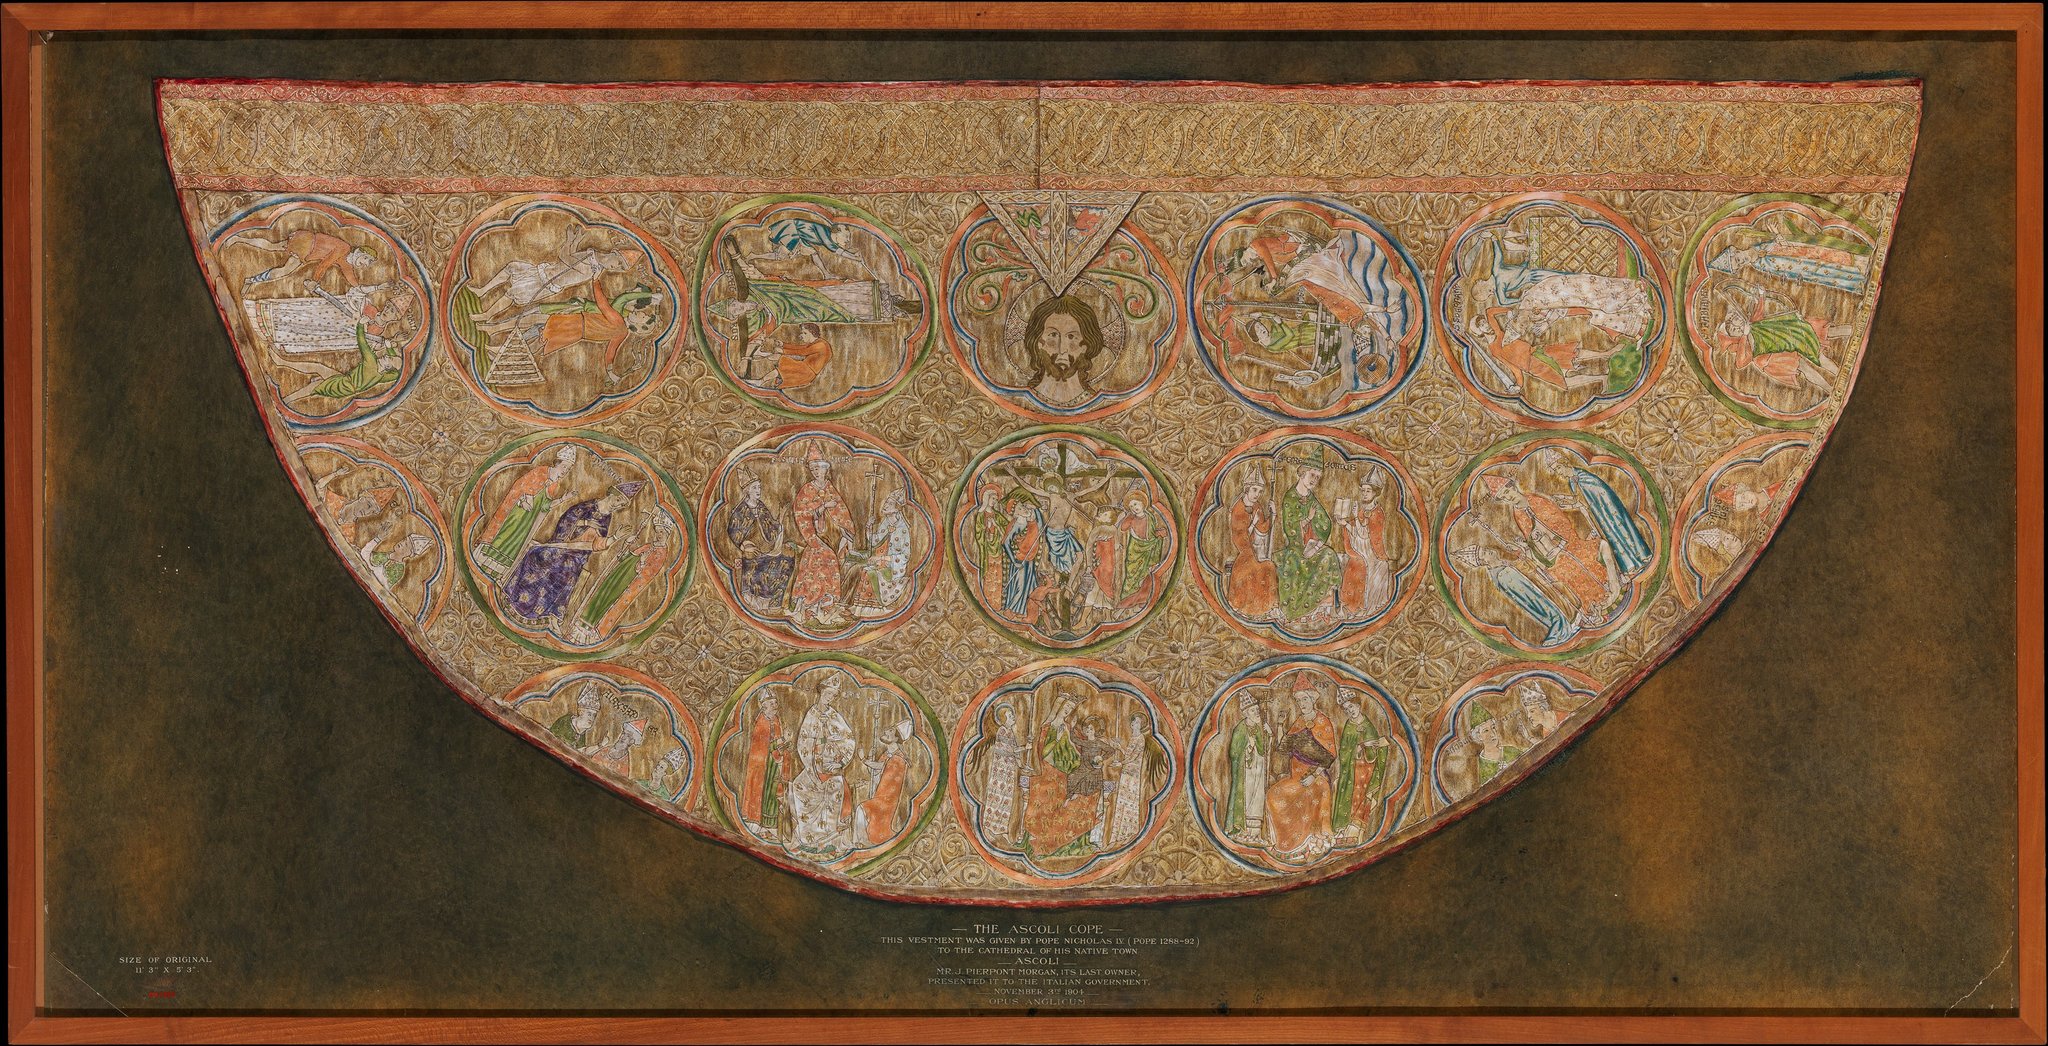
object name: cope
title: Ascoli Cope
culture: italian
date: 1901-1933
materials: paper, watercolor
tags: christ